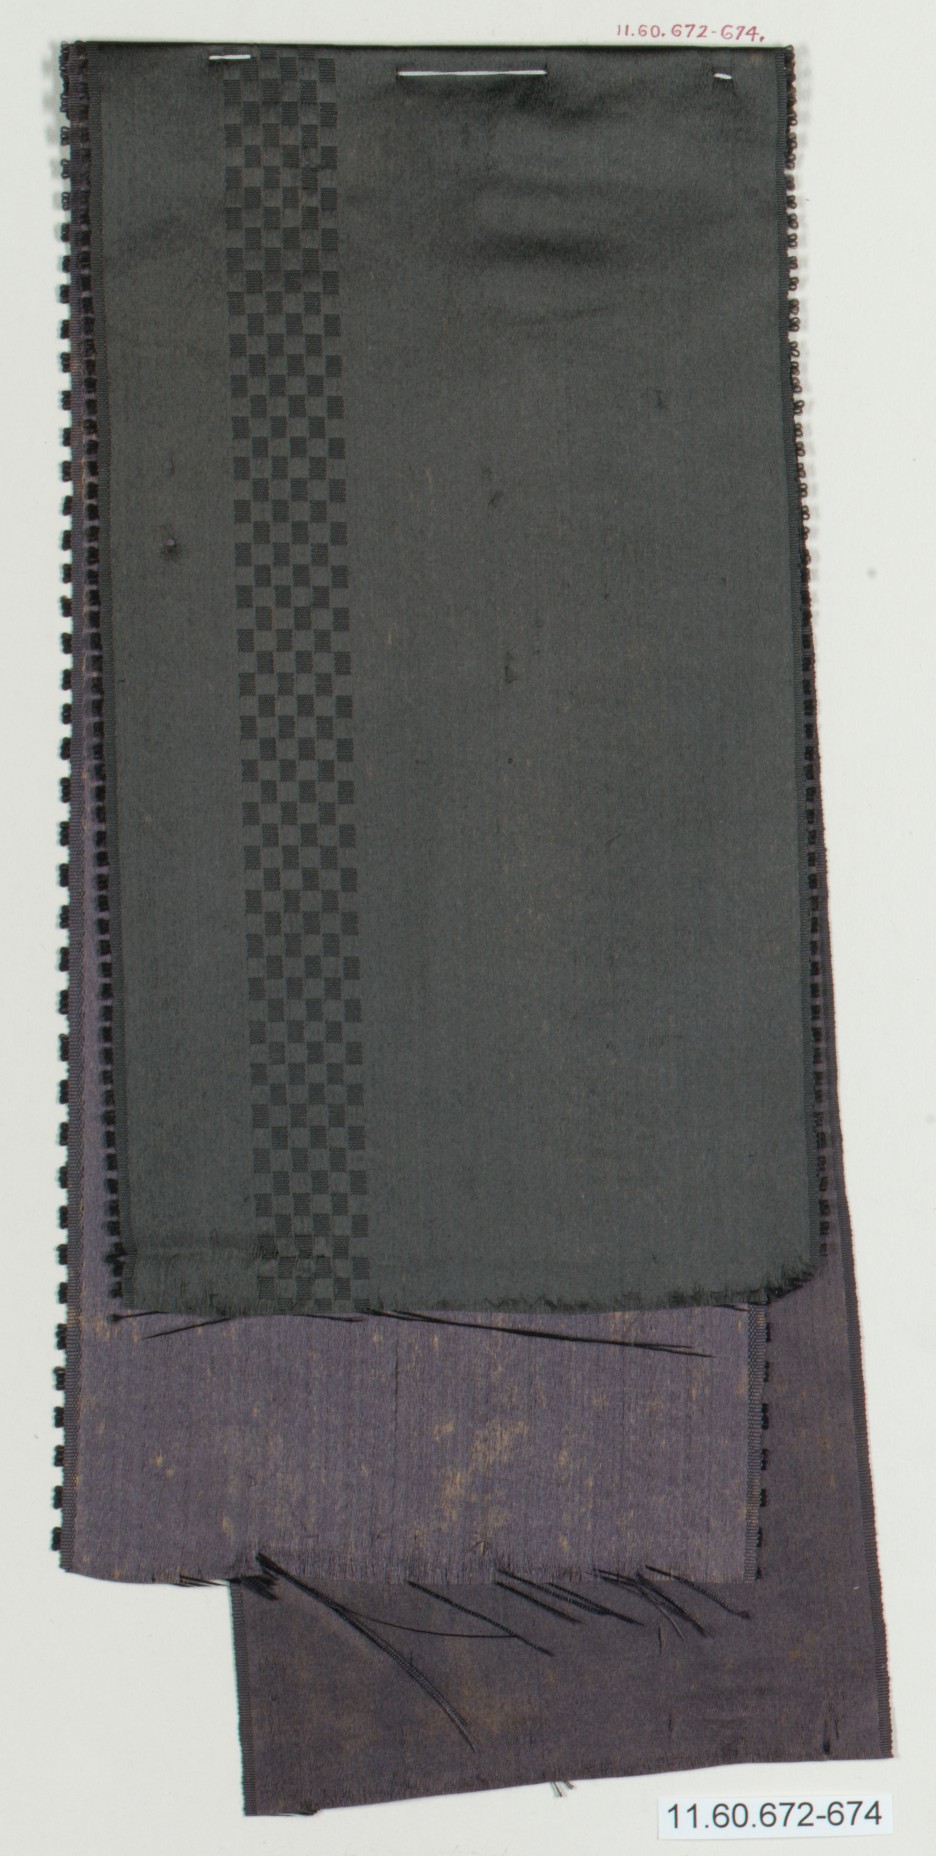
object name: ribbon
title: Ribbons (3)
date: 1801-1900